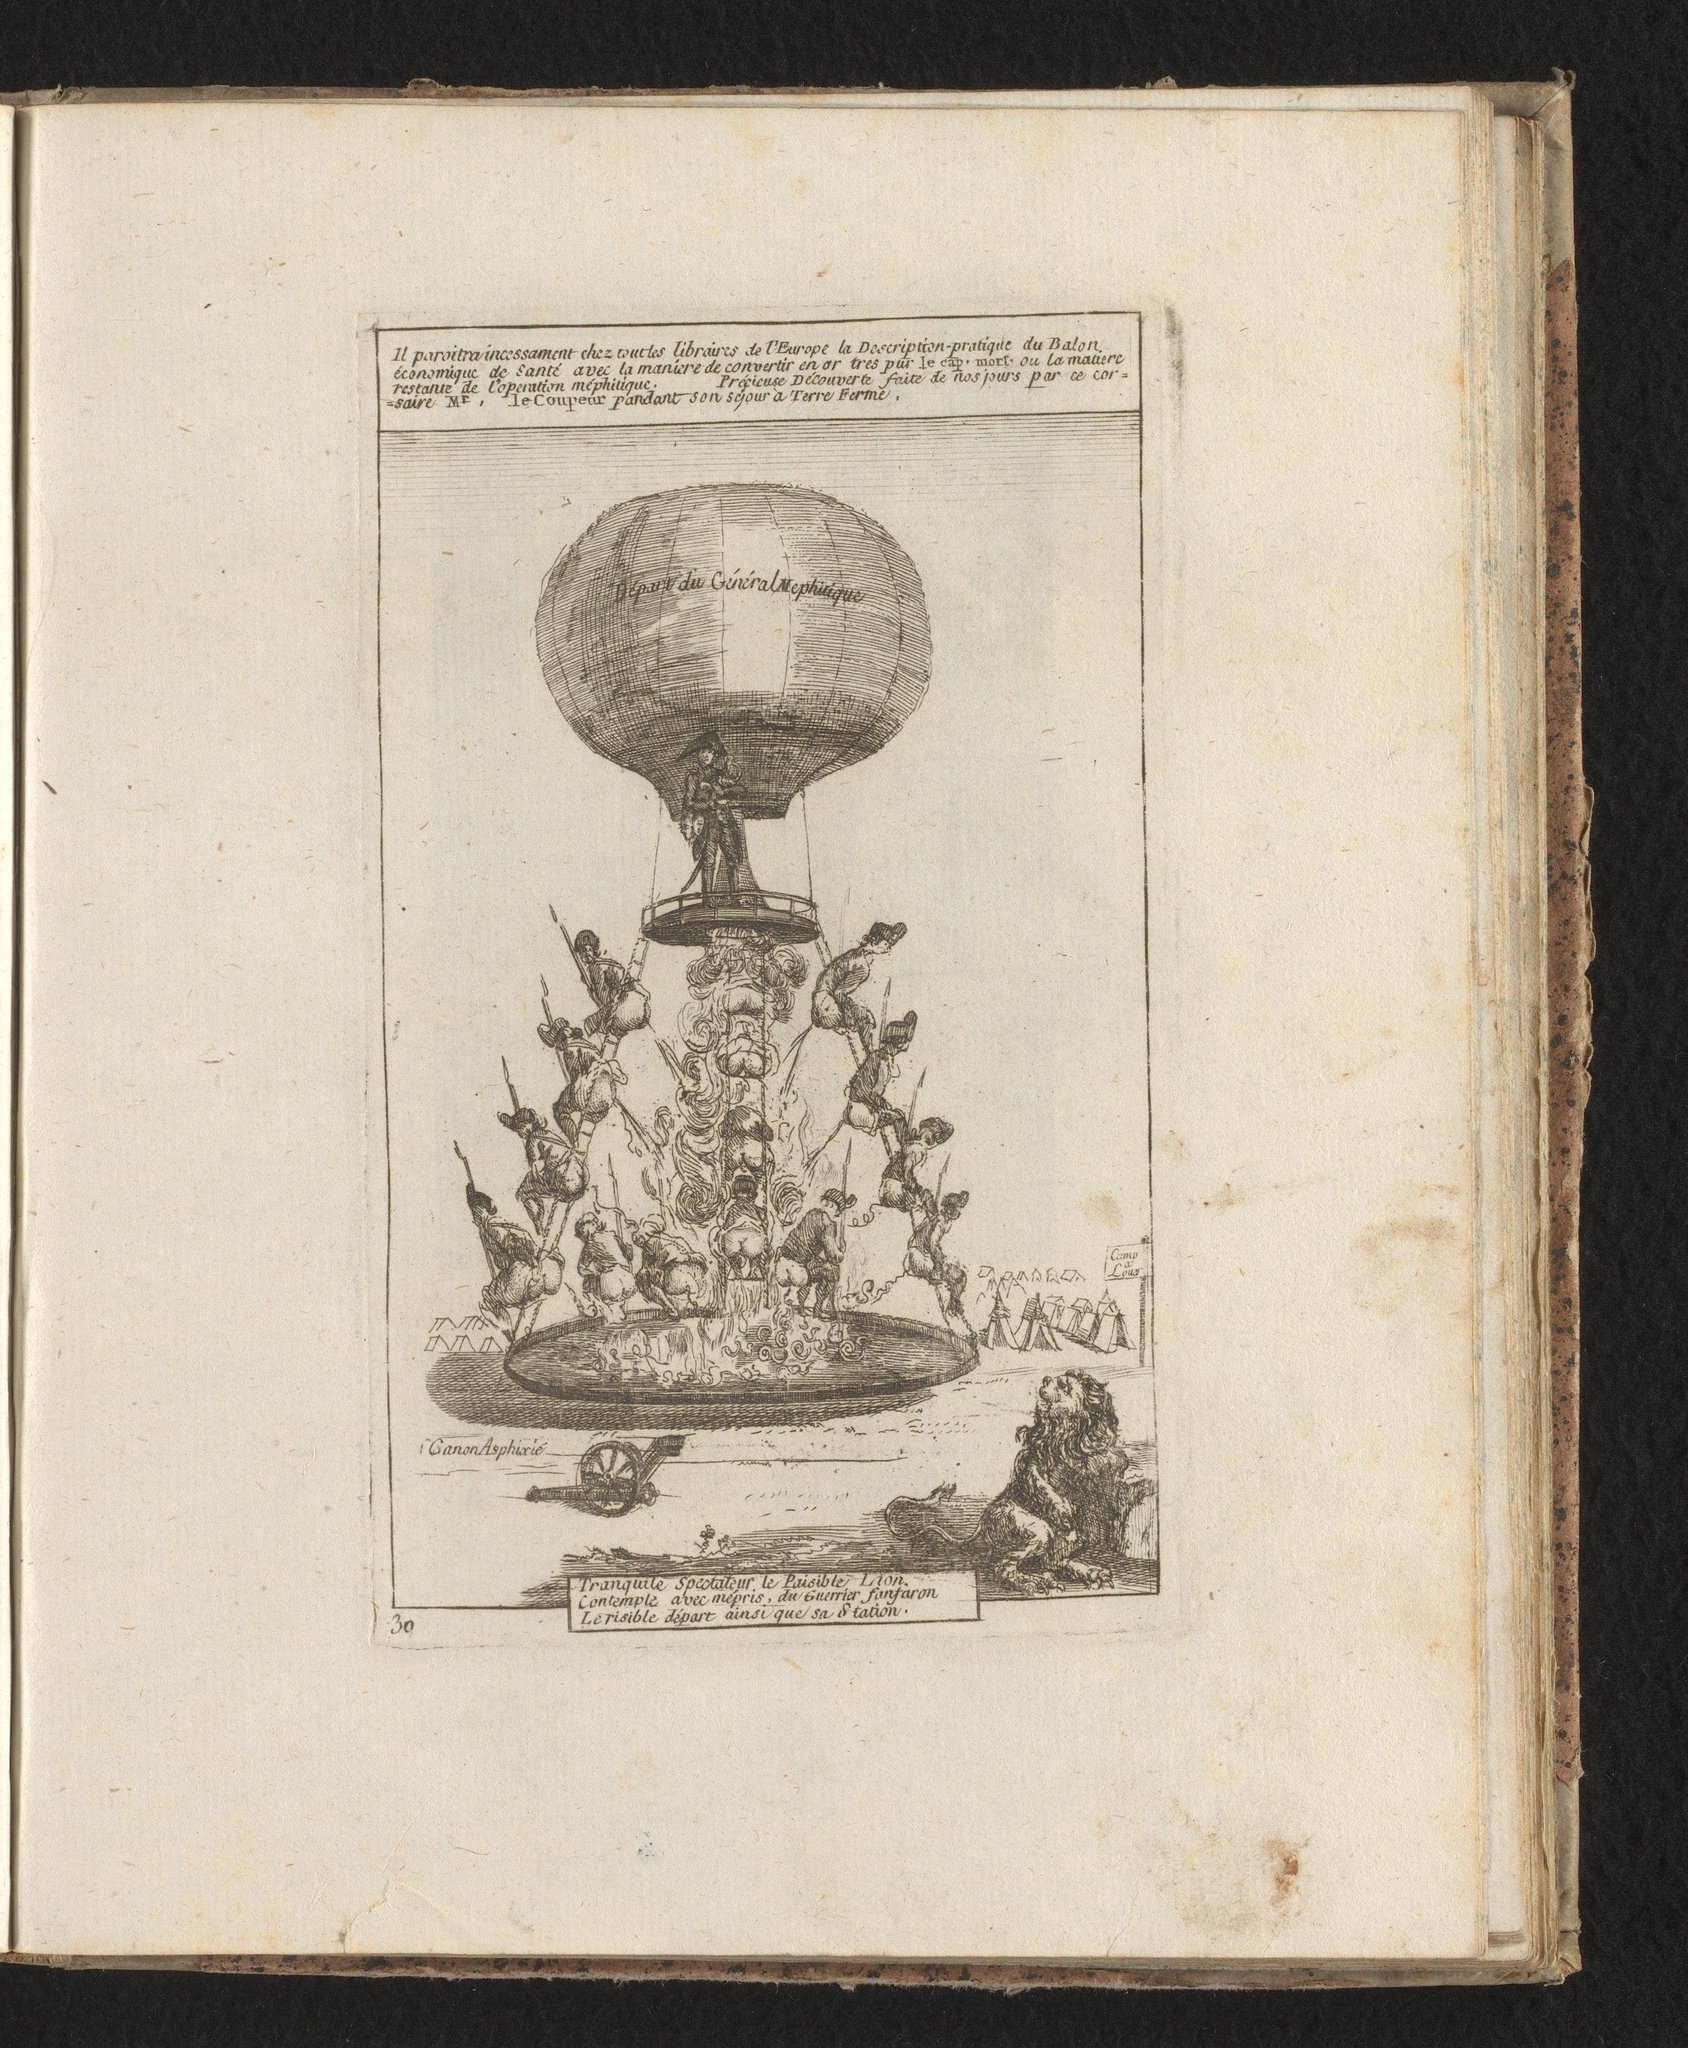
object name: print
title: Départ du Général Mephitique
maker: Anonymous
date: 1787-1790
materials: paper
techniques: etching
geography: southern netherlands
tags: flatulence, balloon (aviation), defecation, brabant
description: Spotprent op een generaal die vertrekt met een luchtballon. Op een trap zitten soldaten met ontbloot achterste, de dampen van hun uitwerpselen vormen de hete lucht waarop de ballon vaart. Rechtsvoor kijkt de Brabantse leeuw toe. Linksonder genummerd: 30. Onderdeel van de gebundelde verzameling prenten betrekking hebbend op de gebeurtenissen van de Brabantse Omwenteling en de periode 1787-1790.